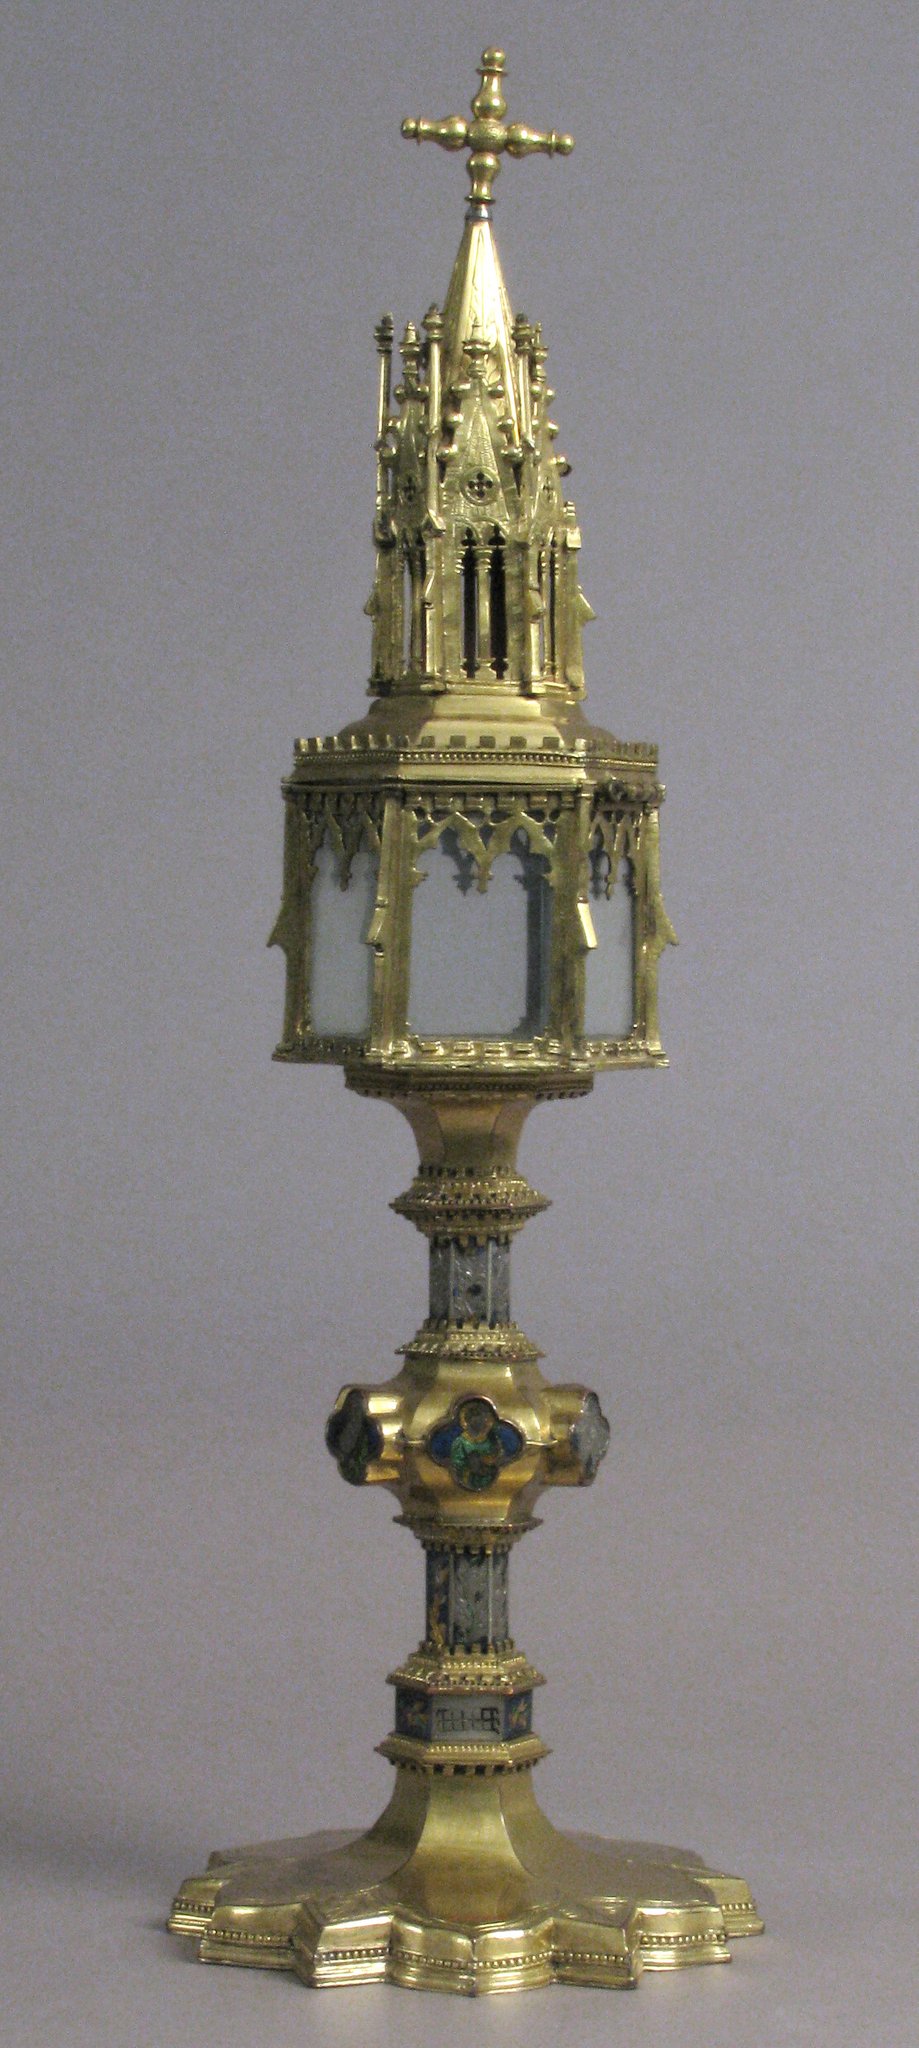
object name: reliquary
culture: italian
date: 1401-1500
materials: gilt copper, enamel, glass, silver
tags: cross